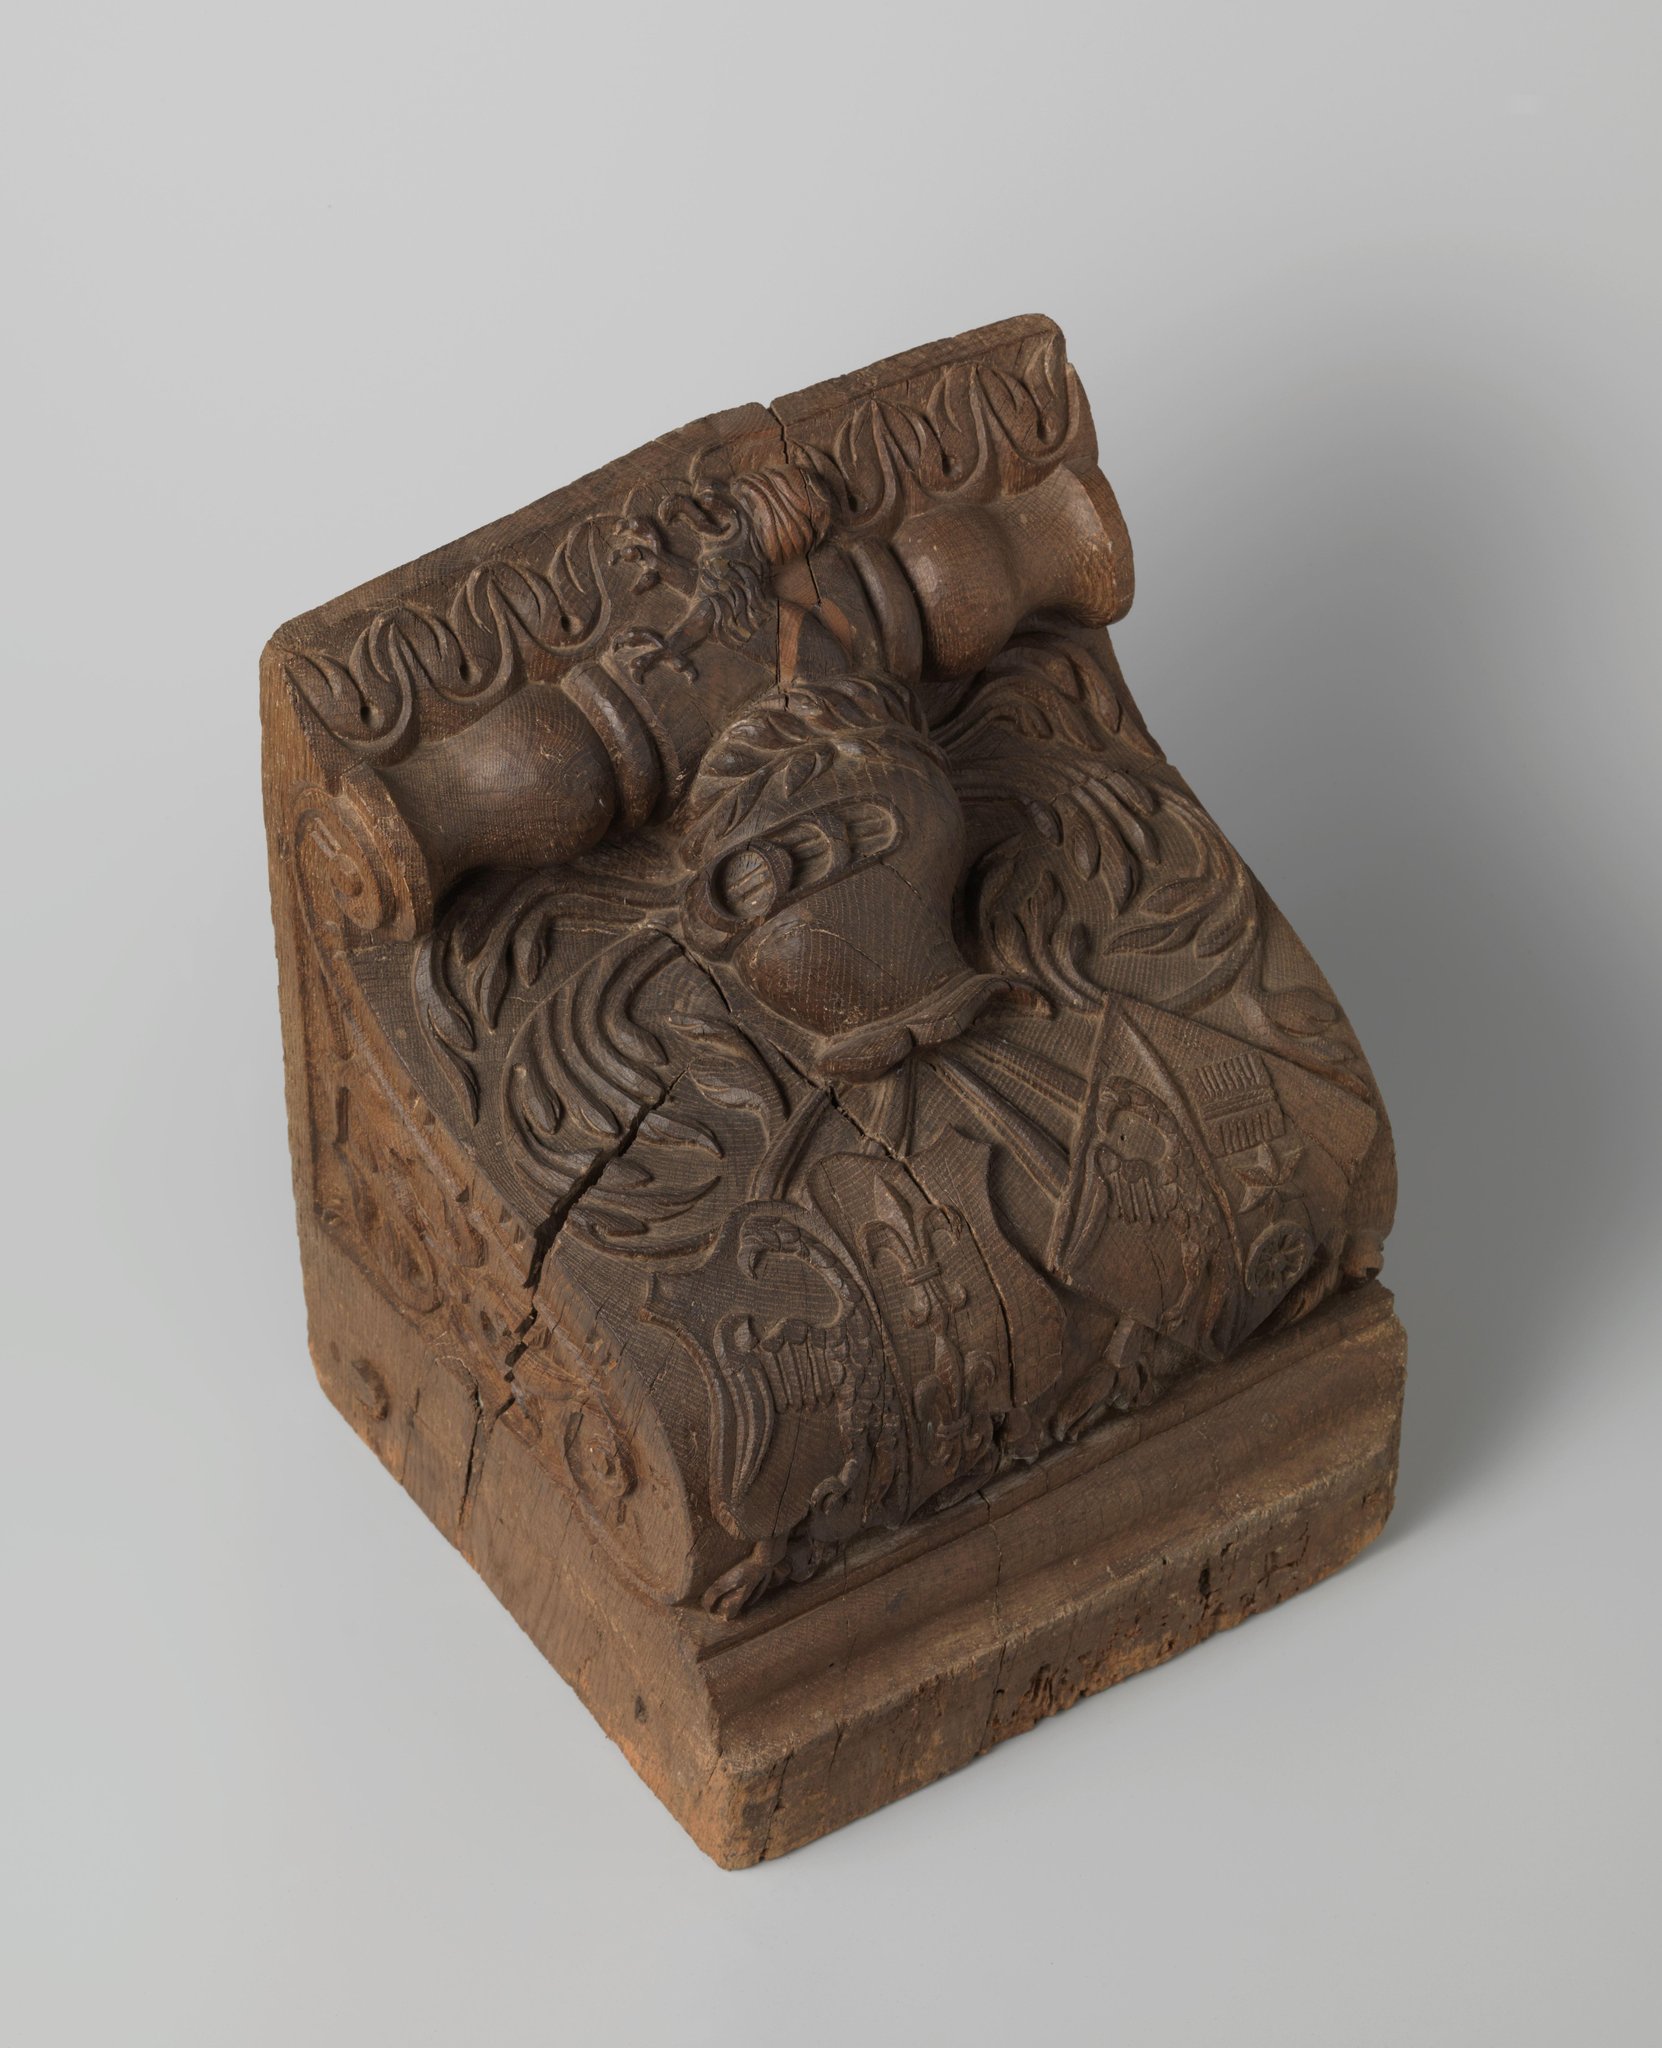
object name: architectural element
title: Korbeel met de familiewapens Dekema en Camstra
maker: Anonymous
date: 1600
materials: wood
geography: northern netherlands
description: Korbeel van eikenhout. Op het consolevormige voorstuk de wapens van de families Dekema en Camstra, waarboven een helm met als helmteken een leeuw. De zijkanten vertonen S-vormige voluten met in de uitgrondingen bloesems. Afkomstig uit de in 1887 gesloopte Stins te Franeker. (Zie ook inv.nr. BK-16706-a t/m -f en BK-16706-h t/m -j)